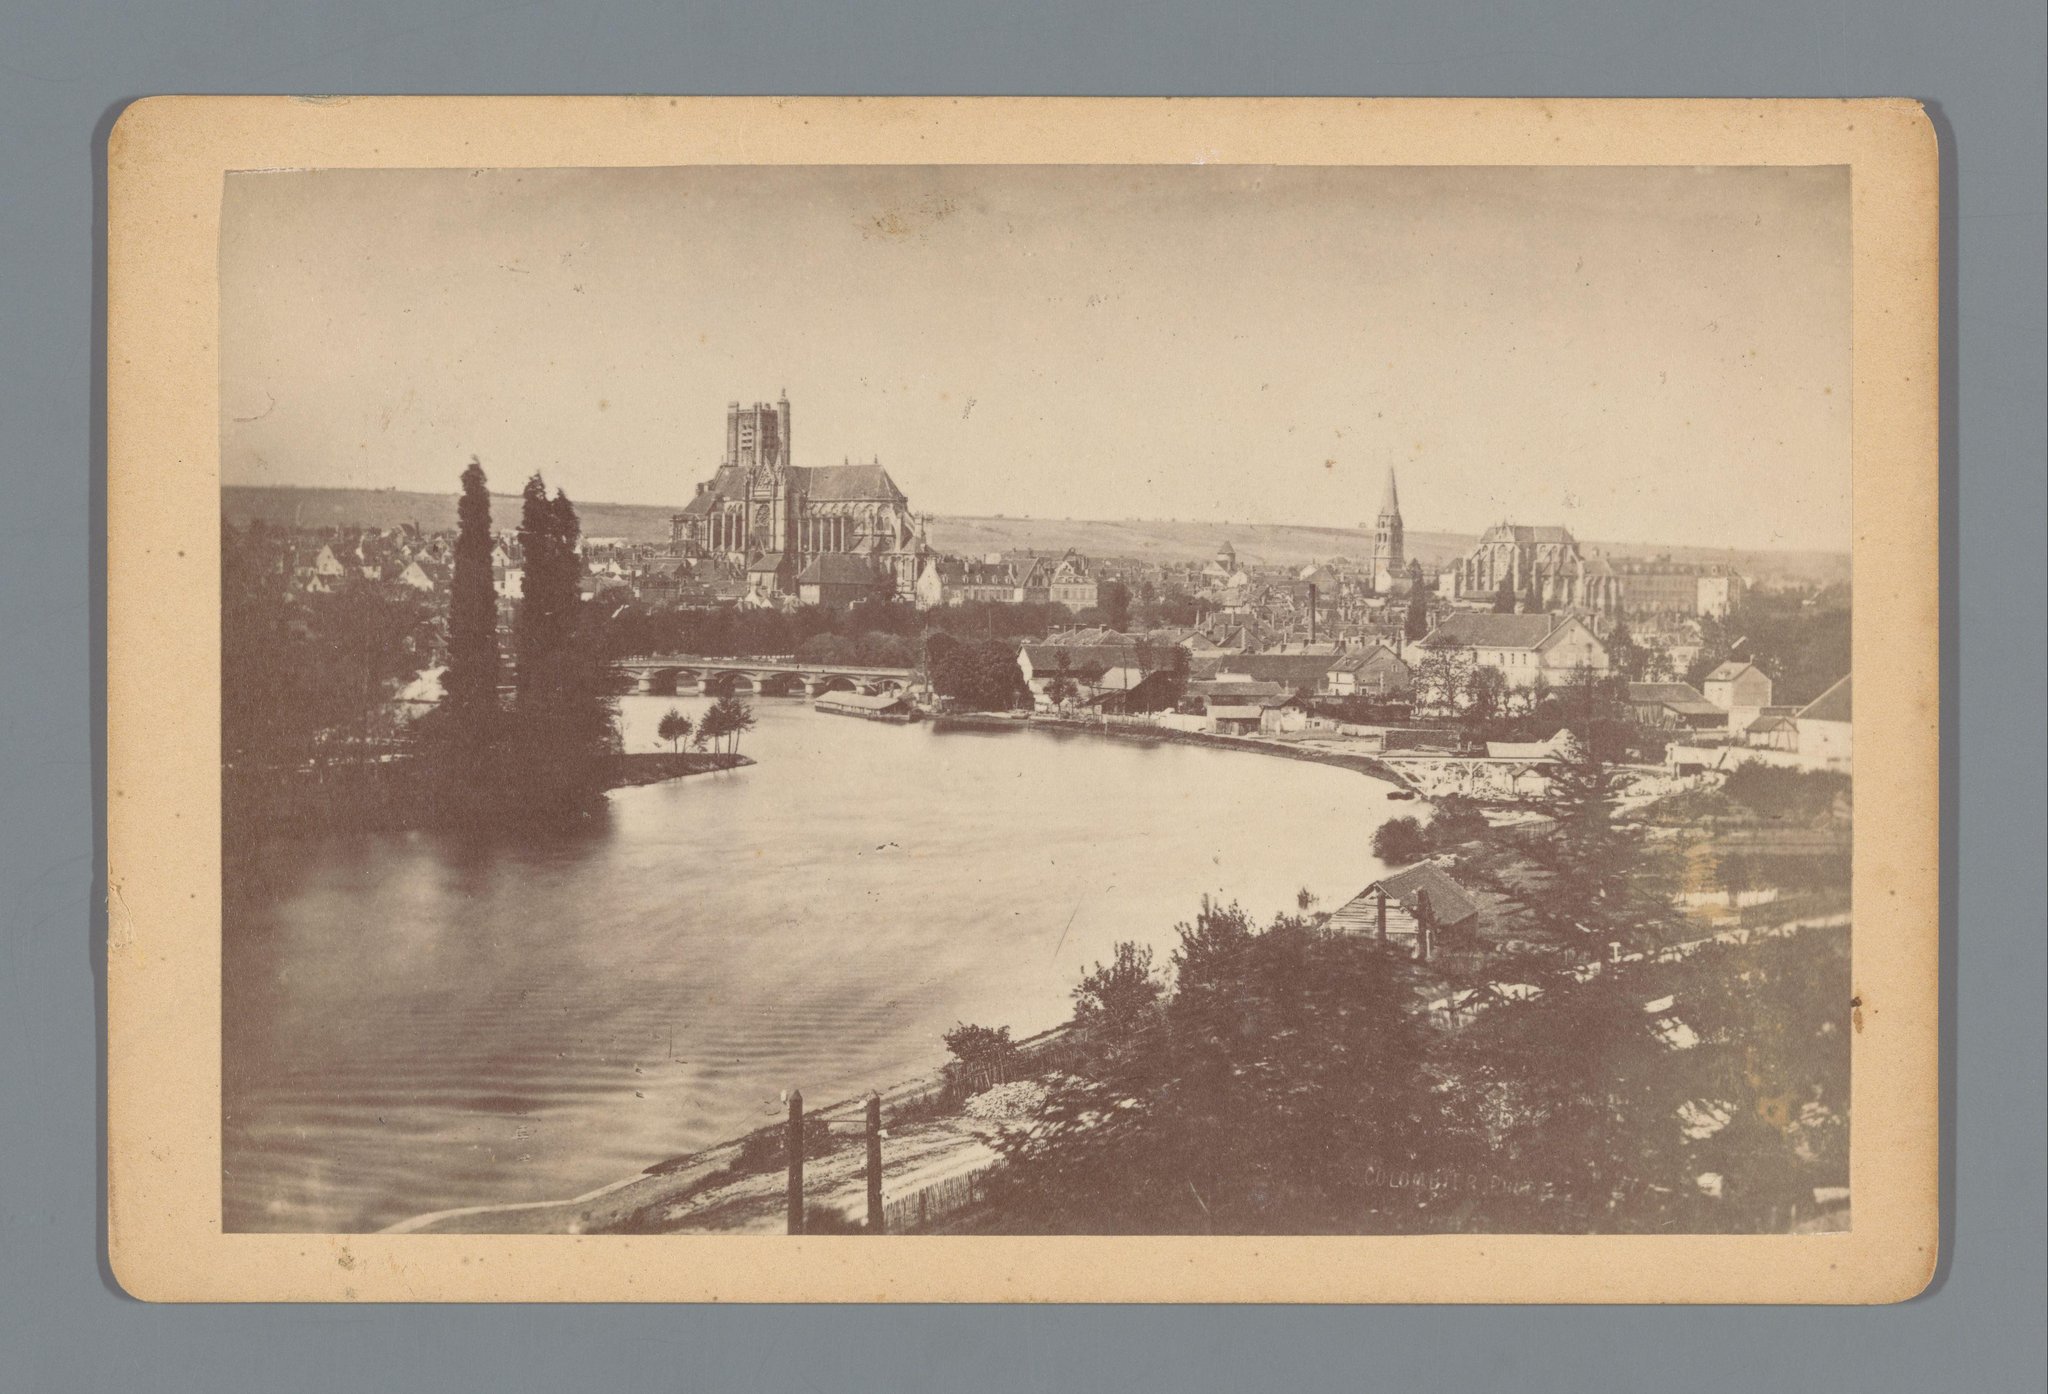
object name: cabinet photograph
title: Gezicht op Auxerre met de kathedraal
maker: louis maillet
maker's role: fotograaf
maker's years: 1845-1911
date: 1893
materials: cardboard, photographic support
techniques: albumen print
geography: auxerre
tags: city-view in general; 'veduta', river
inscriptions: retailer's mark: ‘Ancienne Maison Colombier/ 4, Rue de Temple, 4/ Auxerre/ MEDAILLE d'ARGENTal'EXPOSITION 1882/ (...)’, annotation: ‘Auxerre, 9 Juillet 1893 (av. Lecolle)’